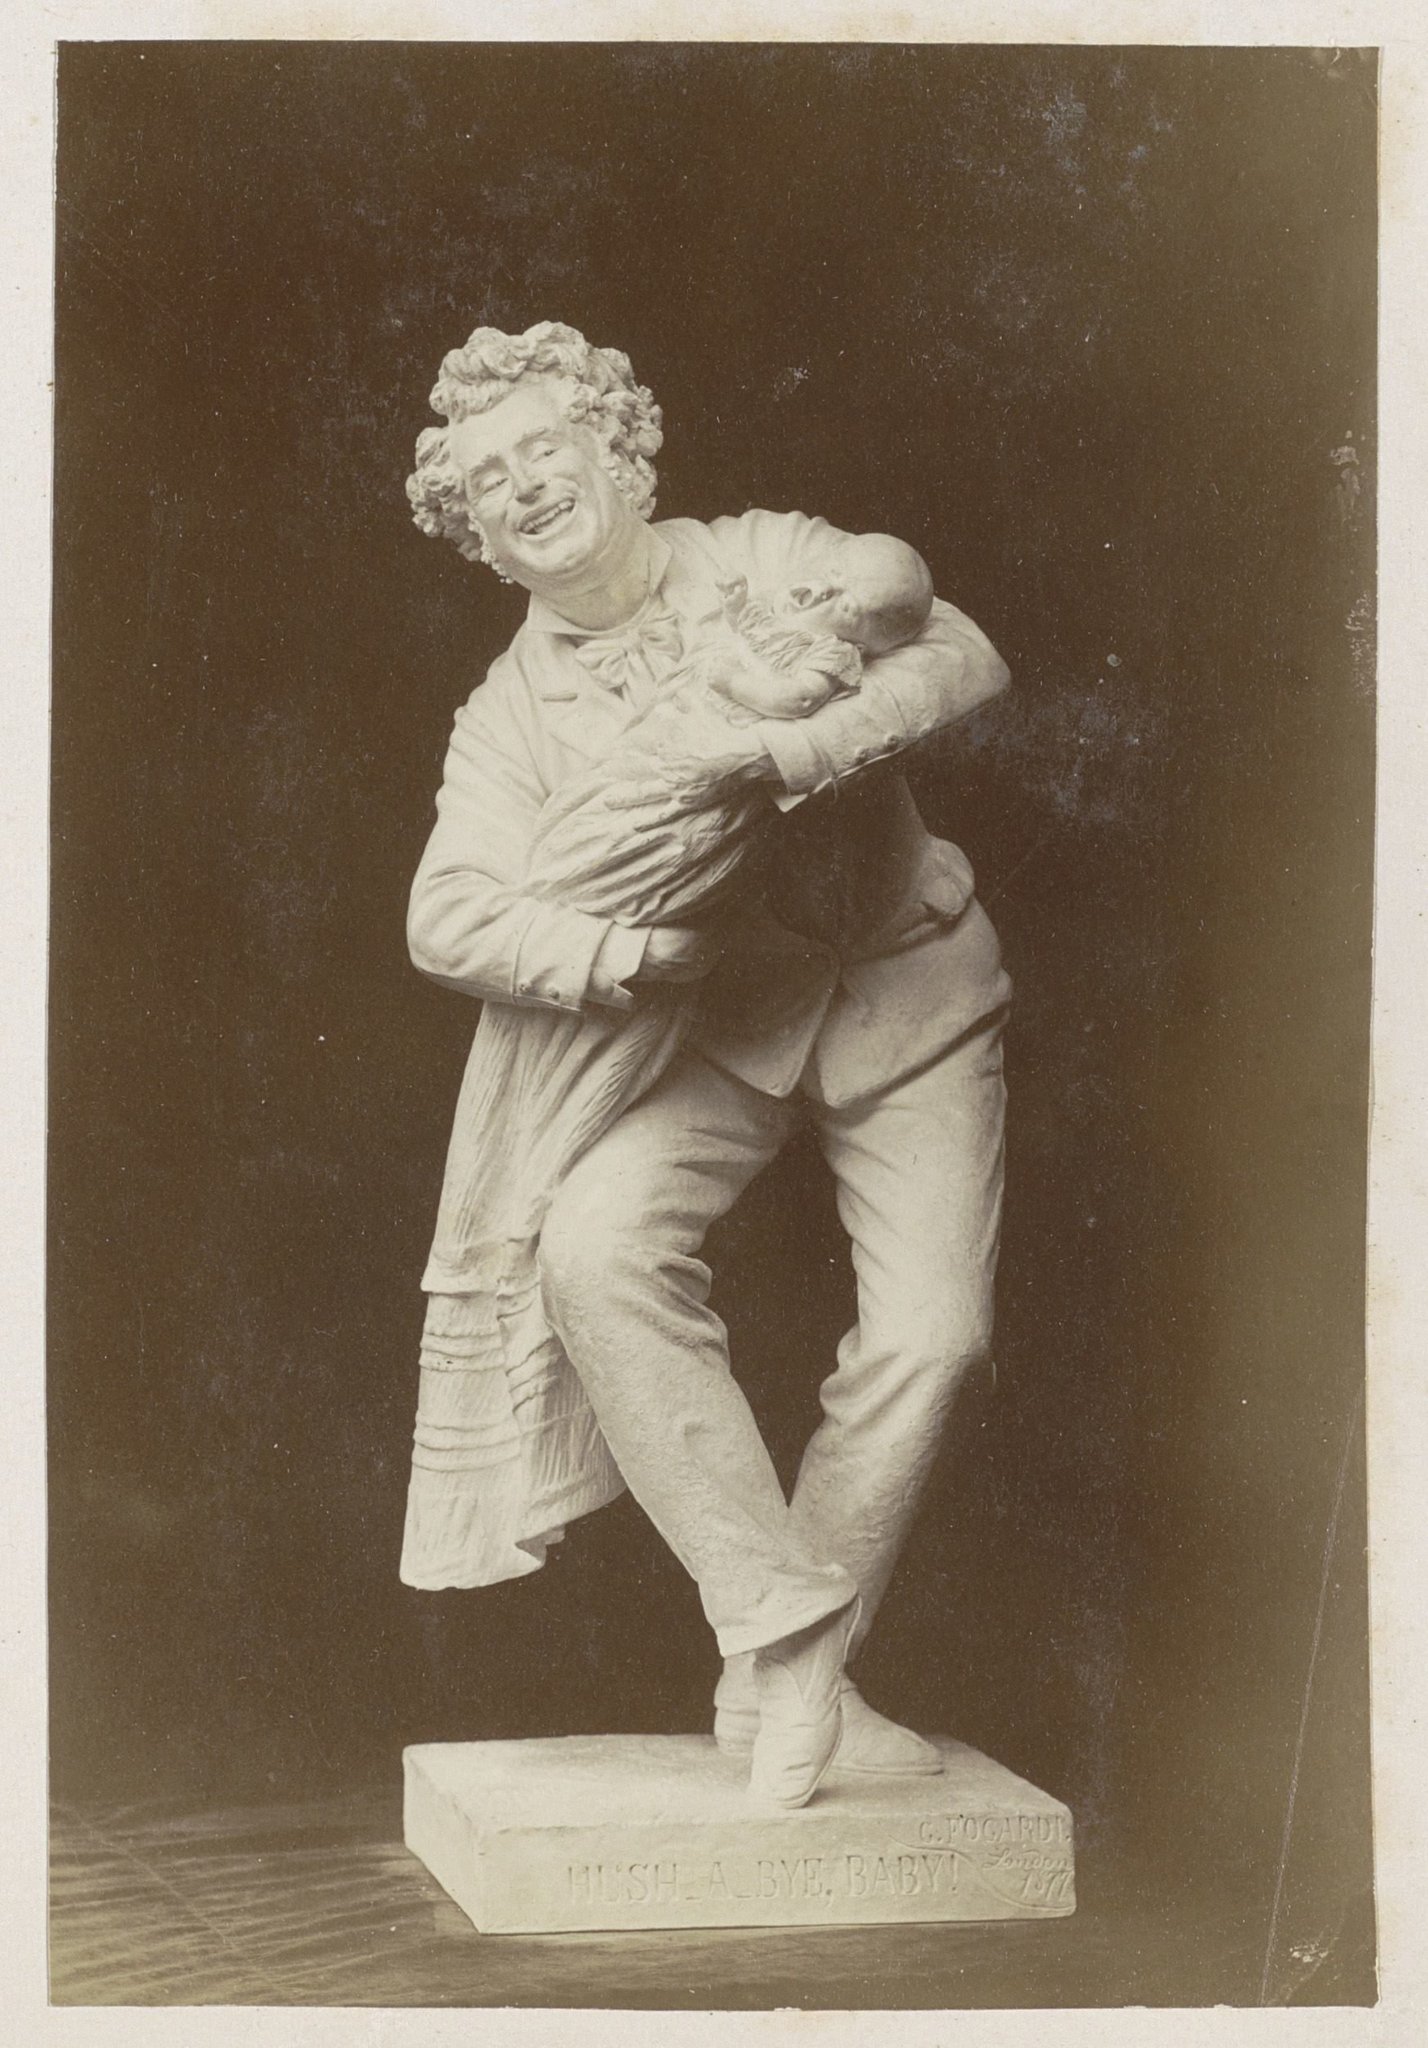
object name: photograph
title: Beeld 'Hush a bye, baby!' van Giovanni Focardi, mogelijk opgesteld op de Wereldtentoonstelling te Parijs in 1889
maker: Anonymous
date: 1878-1890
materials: photographic support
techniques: albumen print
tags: piece of sculpture, reproduction of a piece of sculpture (+ sculpture), world fair, world exhibition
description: Op de voet van het beeld is rechts naast de titel 'Hush a bye, baby!' zichtbaar 'G. Focardi. London 1877'. Onderdeel van Reisalbum Europese steden, vermoedelijk Zweeds.